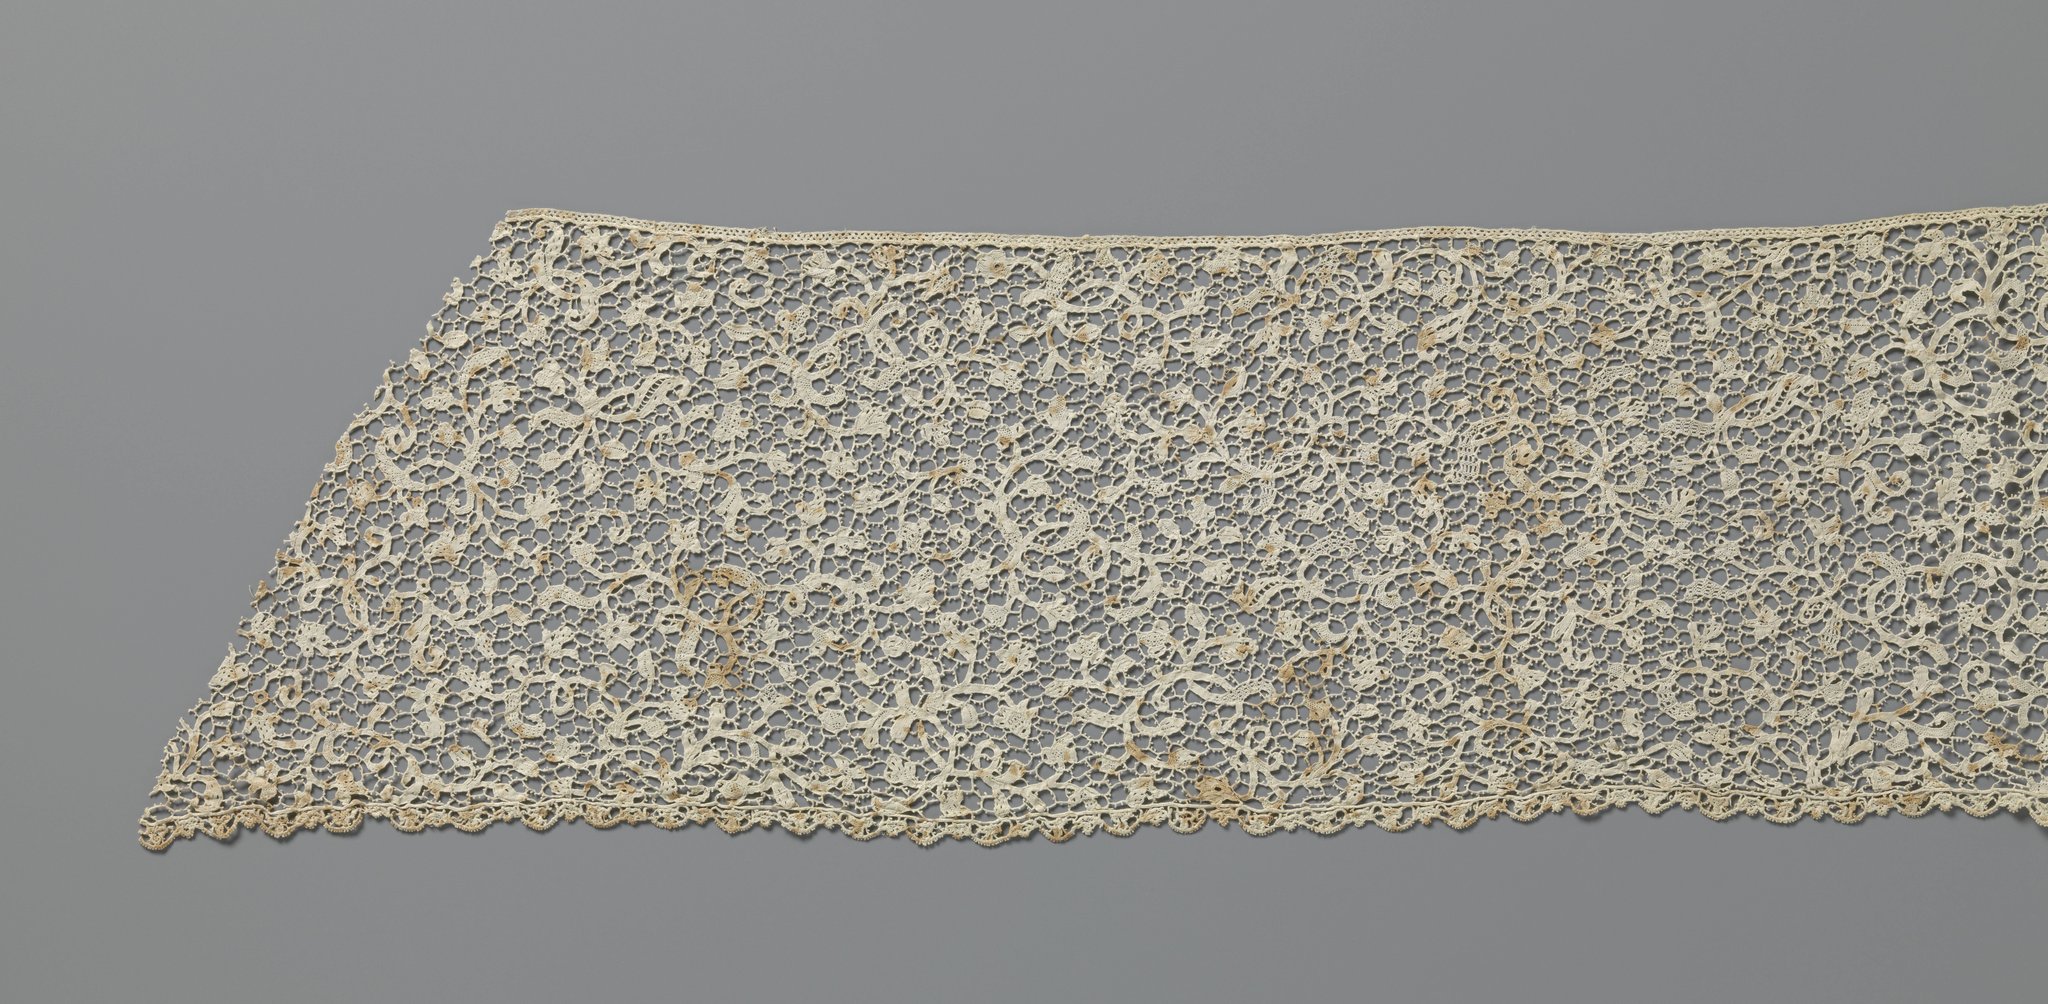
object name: strip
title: Strook naaldkant met fijn spiraalornament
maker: Anonymous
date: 1690-1710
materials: linen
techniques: needle lace, lace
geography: france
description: Strook naturelkleurige naaldkant: point de France. Patroon met een fijn spiraalornament op een zeshoekige spijlengrond met picots. De bovenzijde is afgezet met een rand kloskant. De rechte onderzijde is afgewerkt met gepicoteerde boogjes, waarin motiefjes te zien zijn.